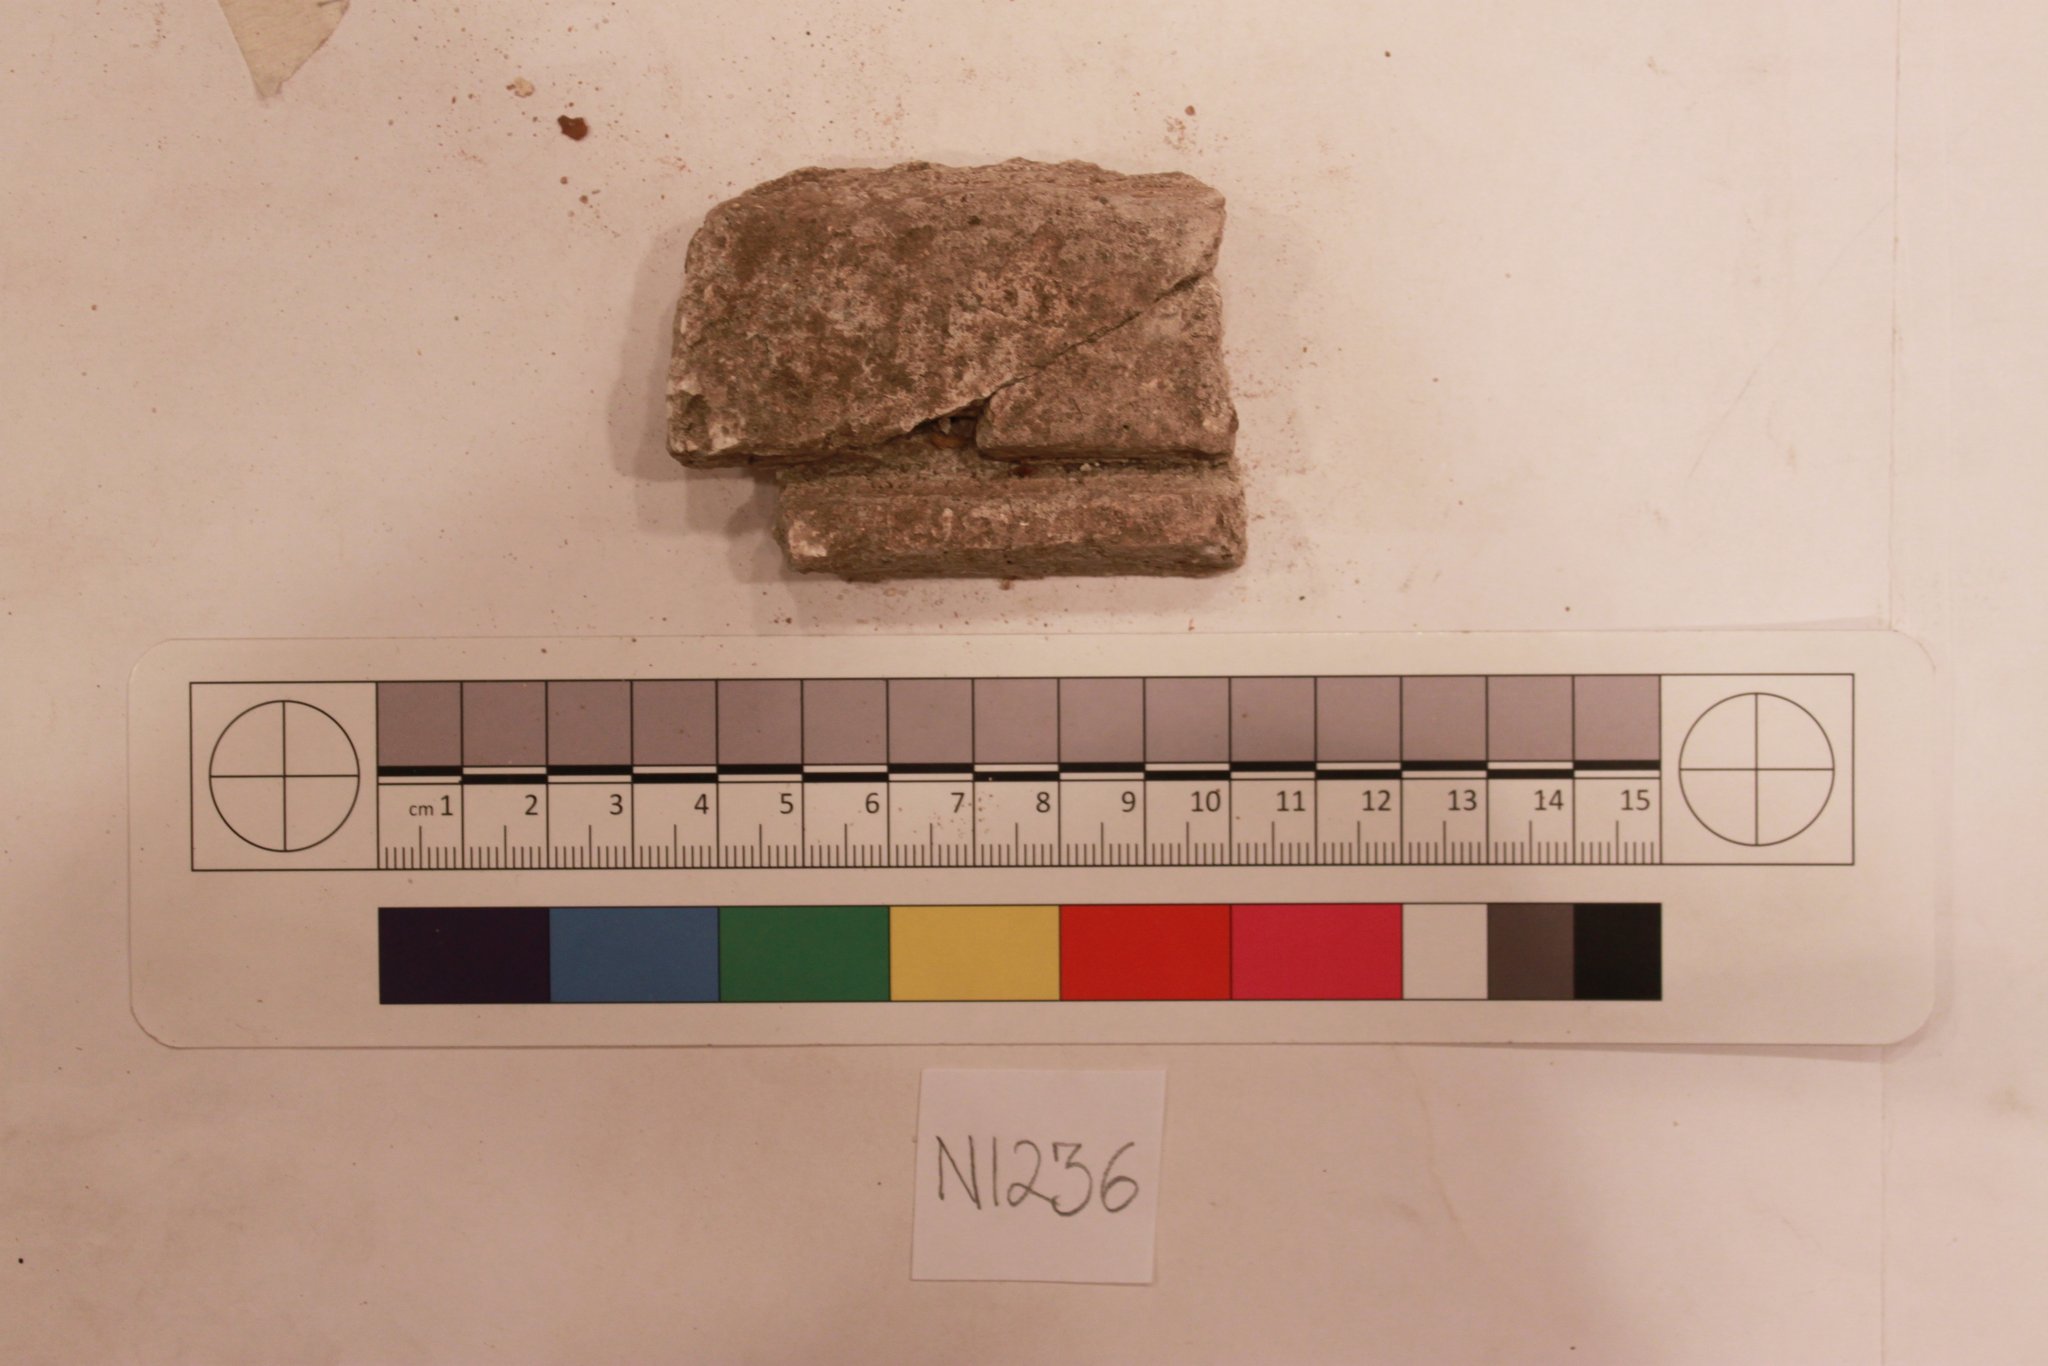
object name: fragment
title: Stucco Fragment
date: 701-1200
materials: plaster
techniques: carving, painting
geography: iran